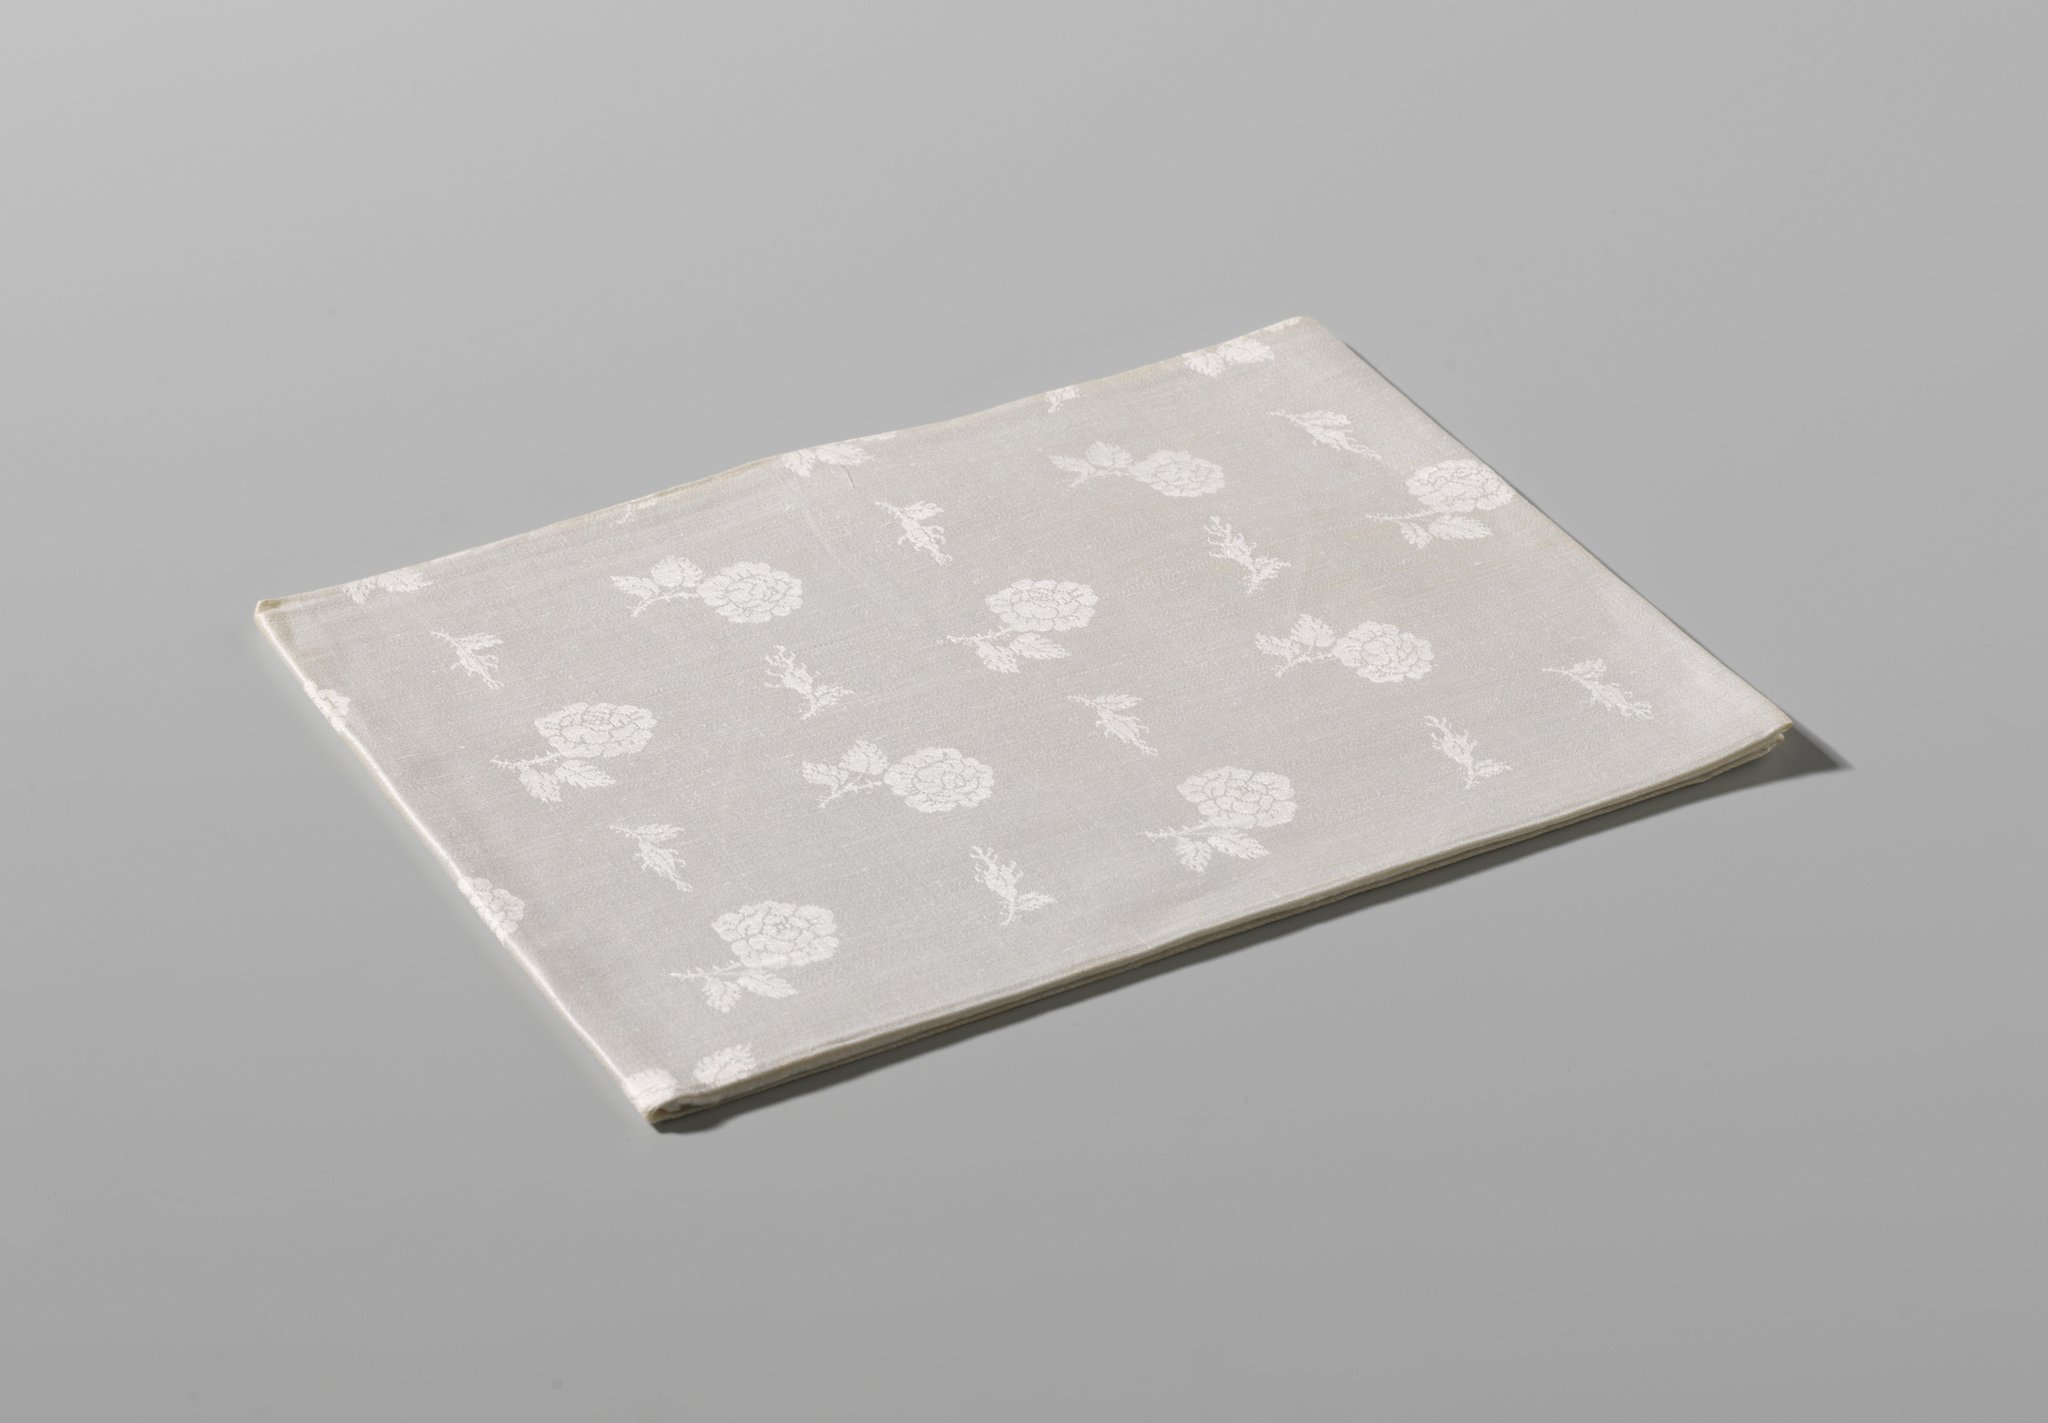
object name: napkin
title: Servet van wit linnendamast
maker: Anonymous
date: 1770-1795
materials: linen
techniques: damask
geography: germany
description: Wit linnen damasten servet met een patroon roosjes en rozenknoppen met een rand van rozetakken en een bloemboeket in de hoeken. Merk BSG en 42.